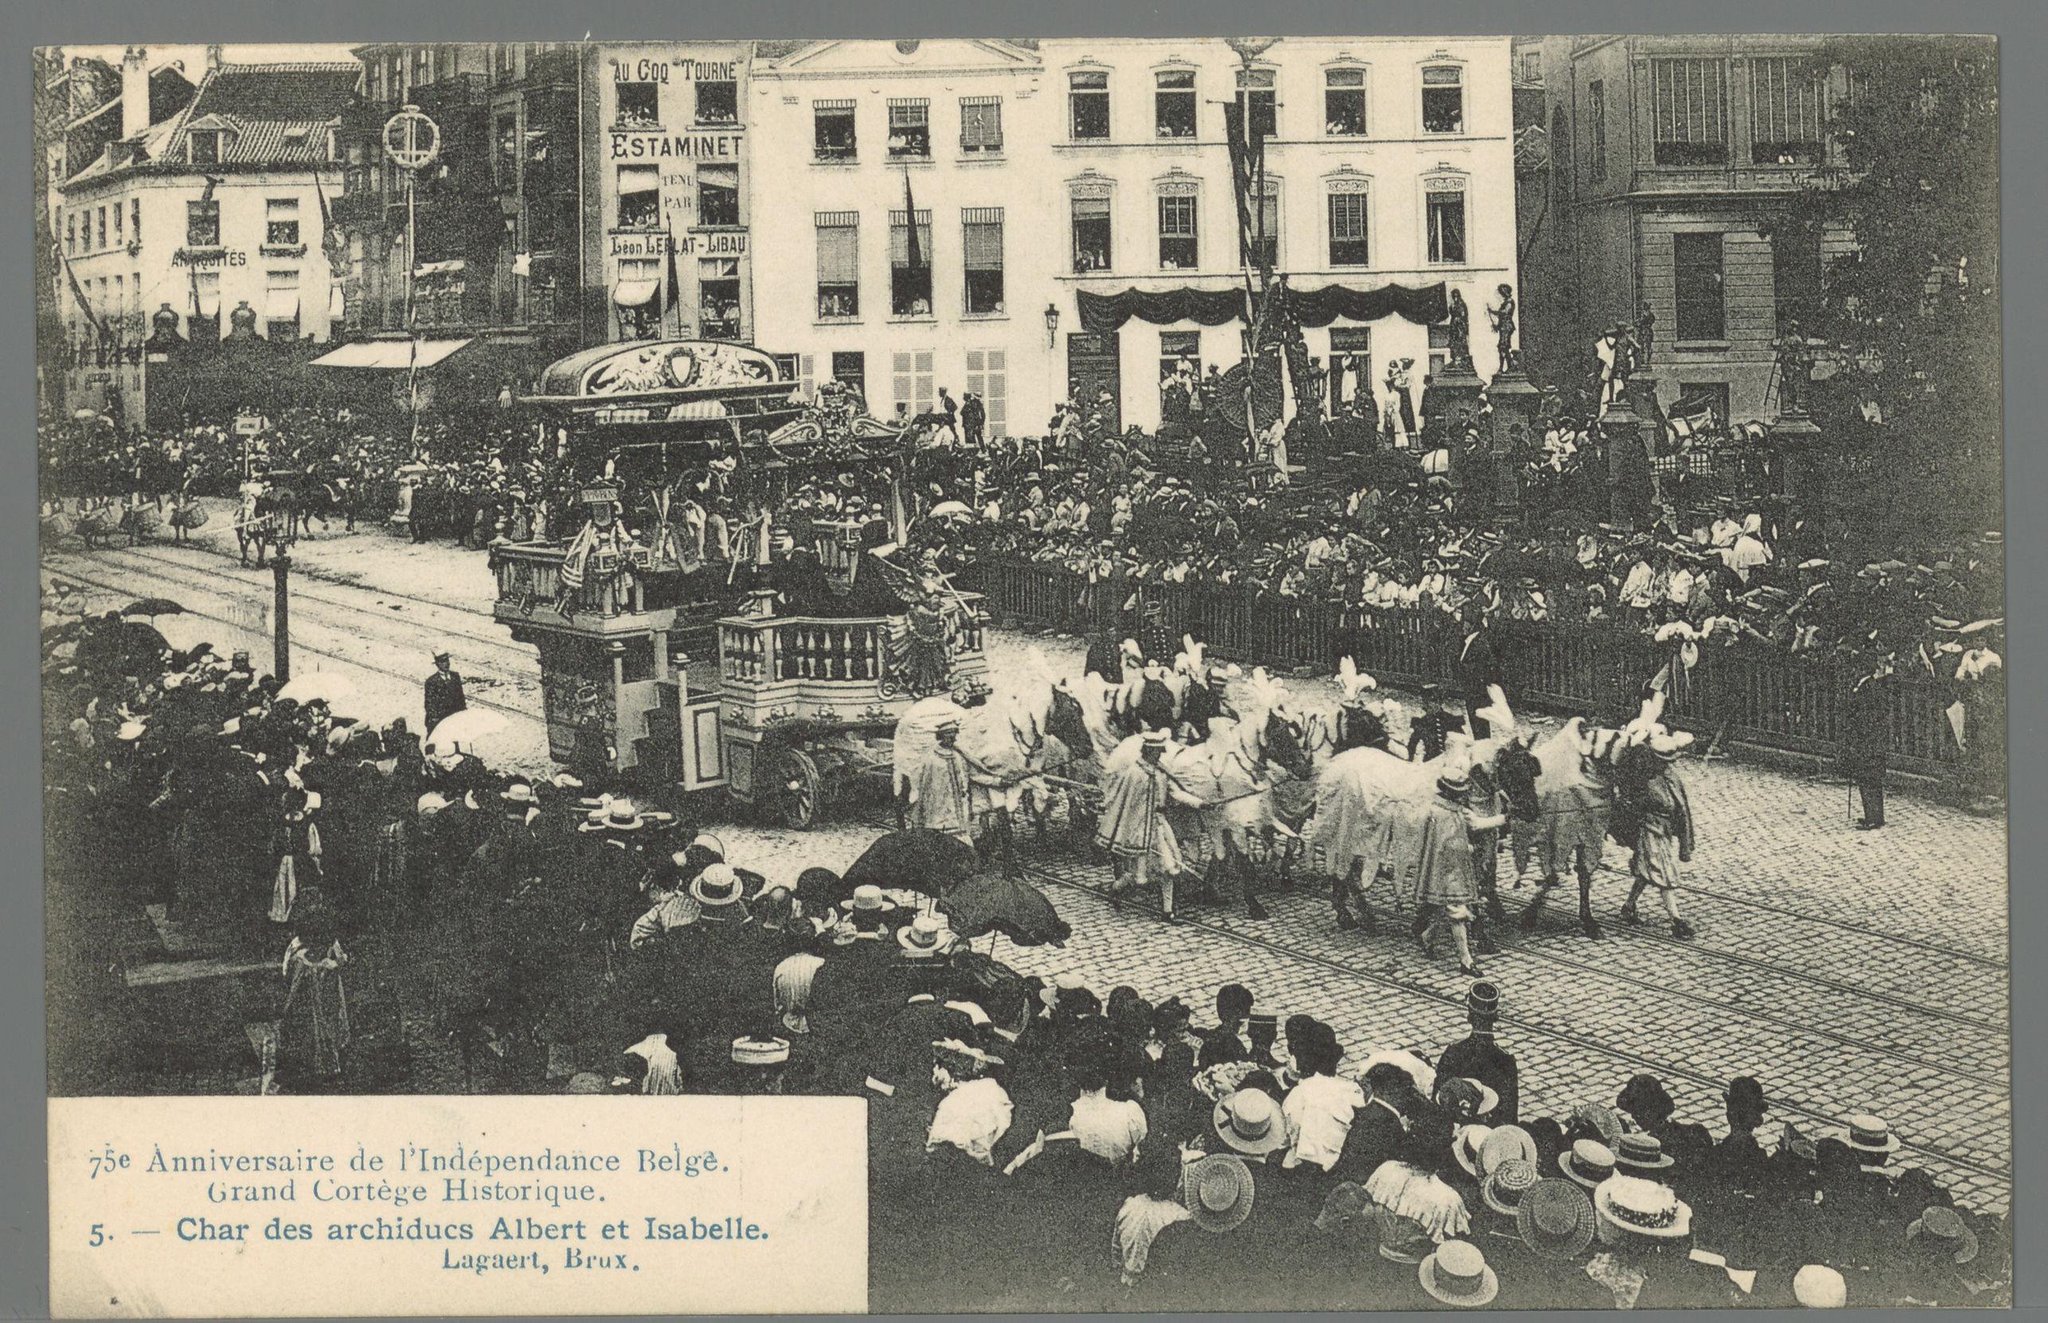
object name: ansichtkaart, prentbriefkaart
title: Char des archiducs Albert et Isabelle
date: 1905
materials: cardboard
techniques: photograph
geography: schaarbeek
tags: city-view, and landscape with man-made constructions (+ city(-scape) with figures, staffage), periodic celebrations, popular feasts, brussels